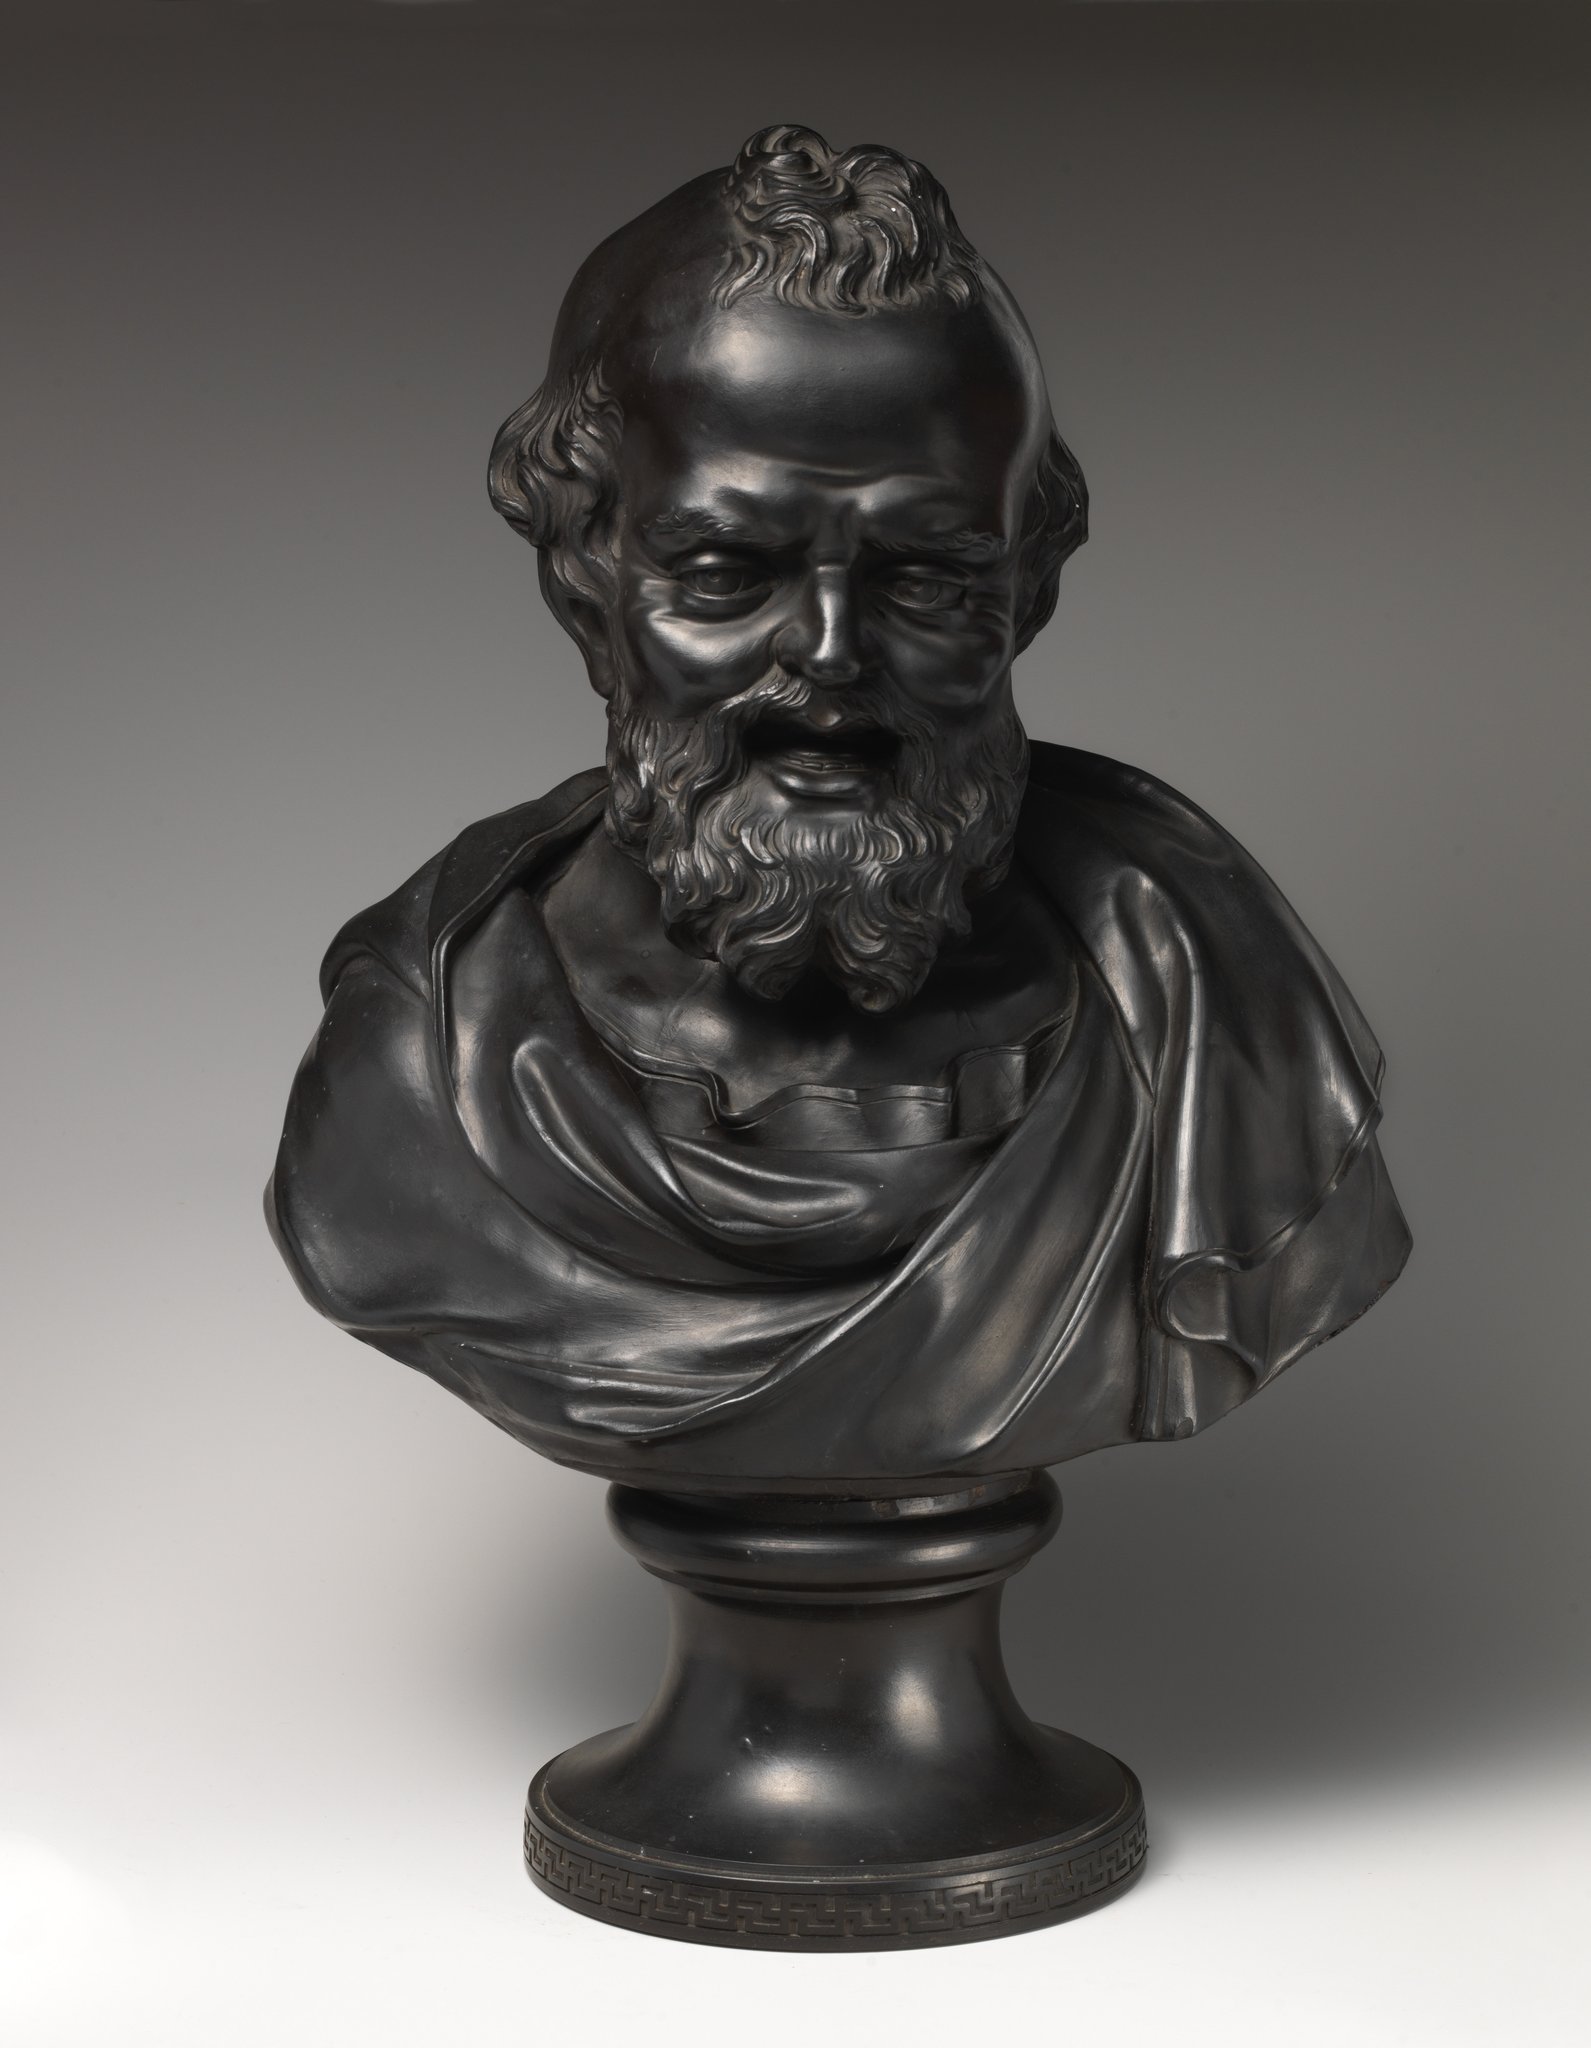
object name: bust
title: Democritus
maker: wedgwood and bentley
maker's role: maker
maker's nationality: british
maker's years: 1769-1780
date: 1701-1800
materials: stone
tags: men,portraits